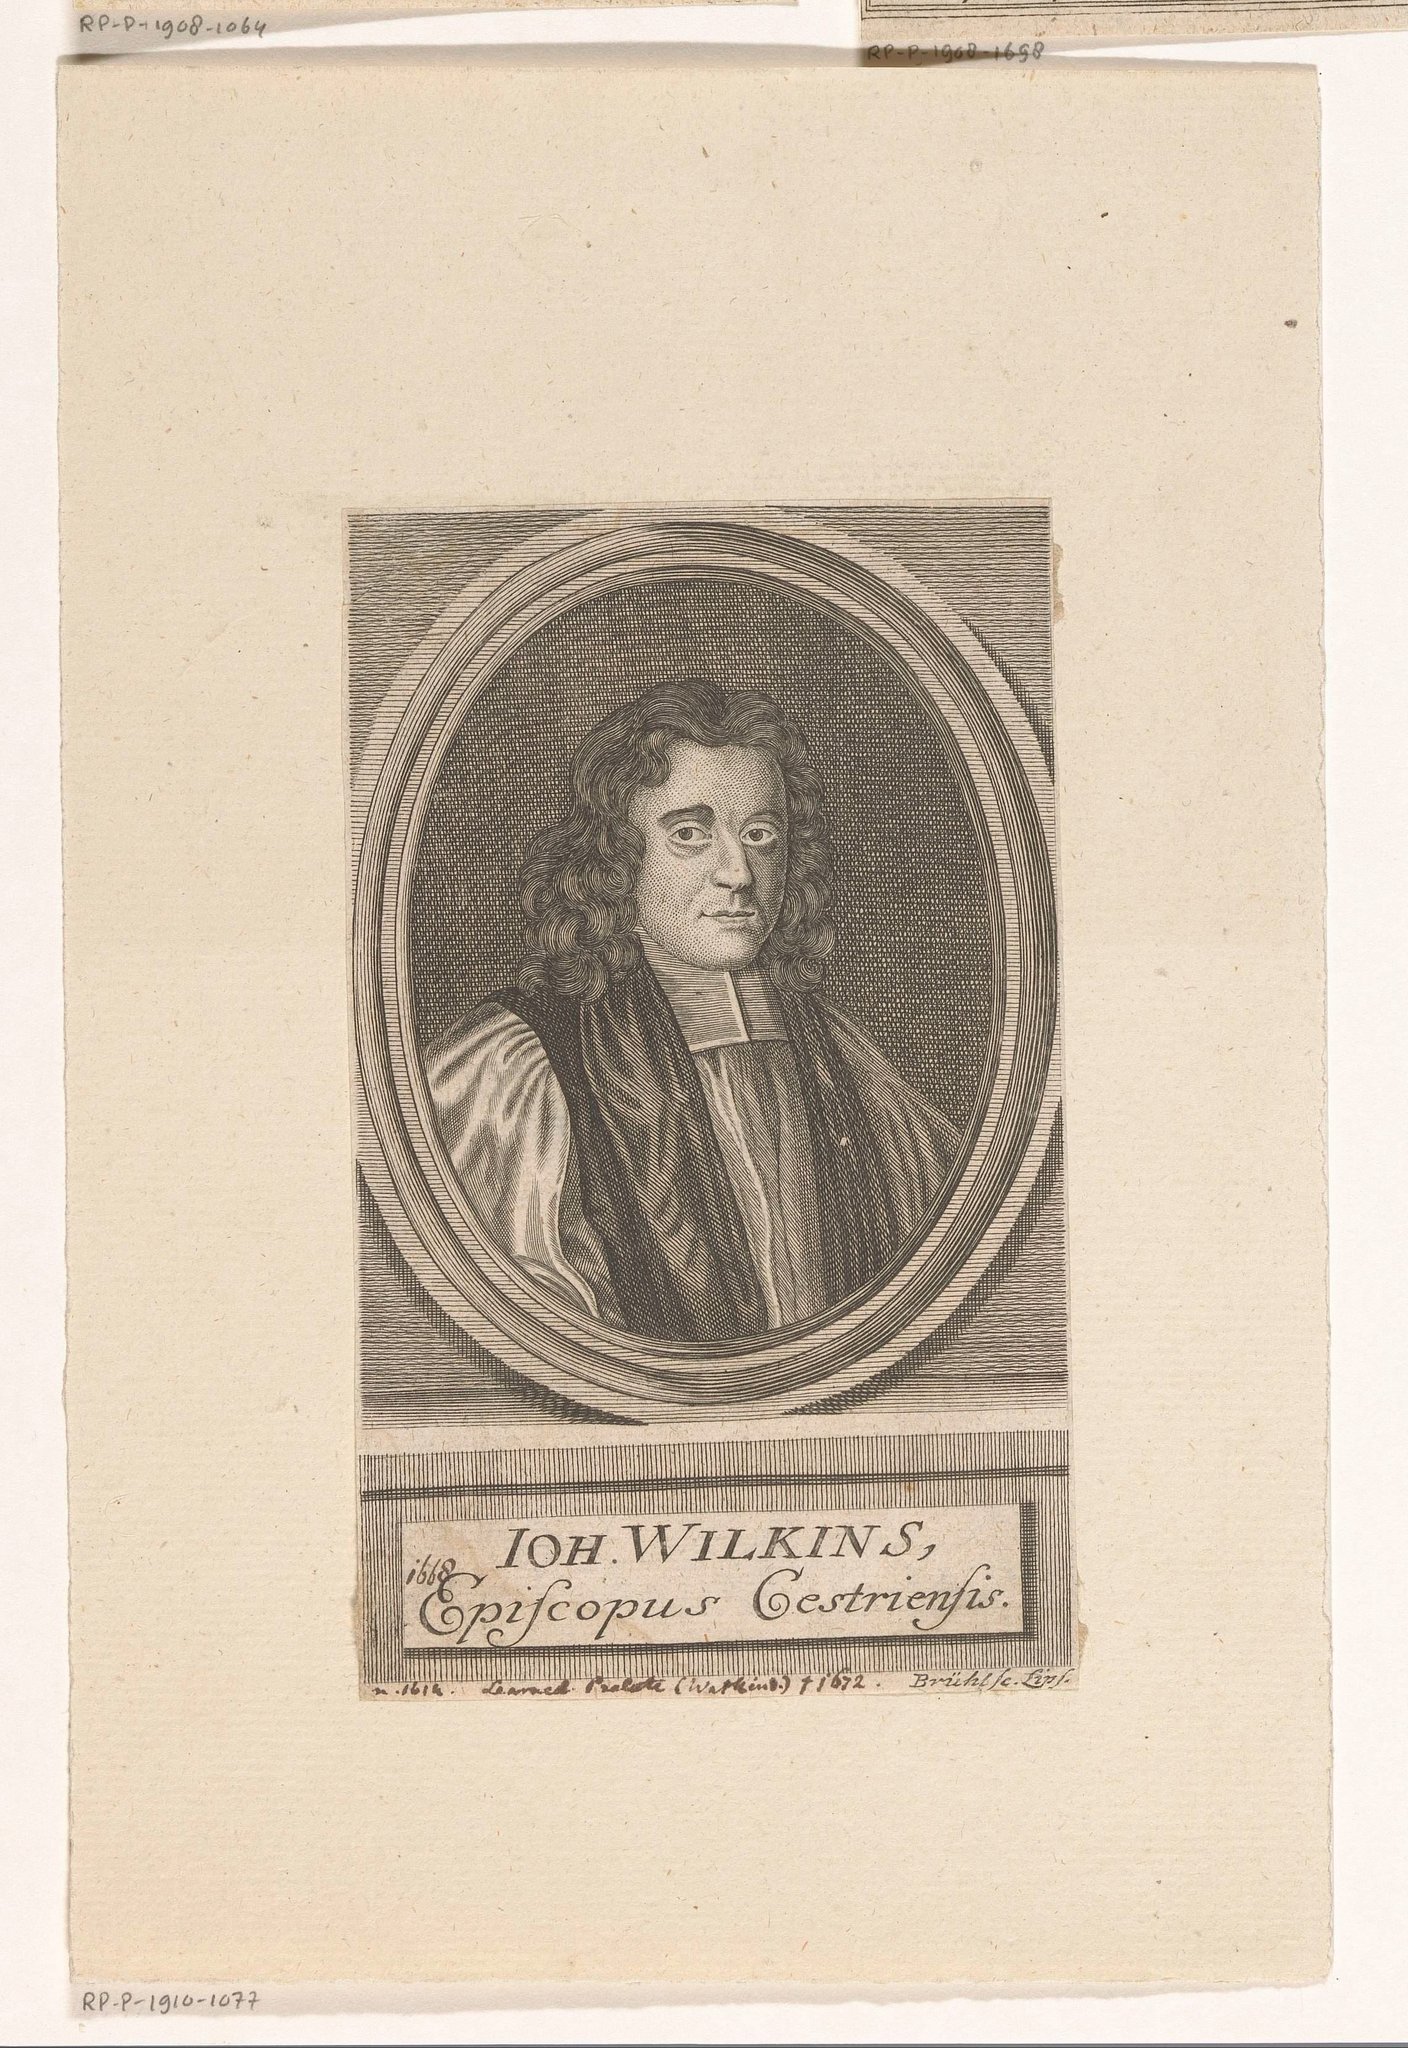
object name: print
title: Portret van John Wilkins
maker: johann benjamin brühl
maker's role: print maker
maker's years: 1691-1763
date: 1734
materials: paper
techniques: engraving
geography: leipzig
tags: historical persons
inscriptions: collector's mark: Lugt 2228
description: Prent ook gebruikt in: Fortgesetzte Sammlung Von Alten und Neuen Theologischen Sachen (...) Dritter Beytrag Auf das Jahr 1734. Leipzig: erven Johann Friedrich Braun.